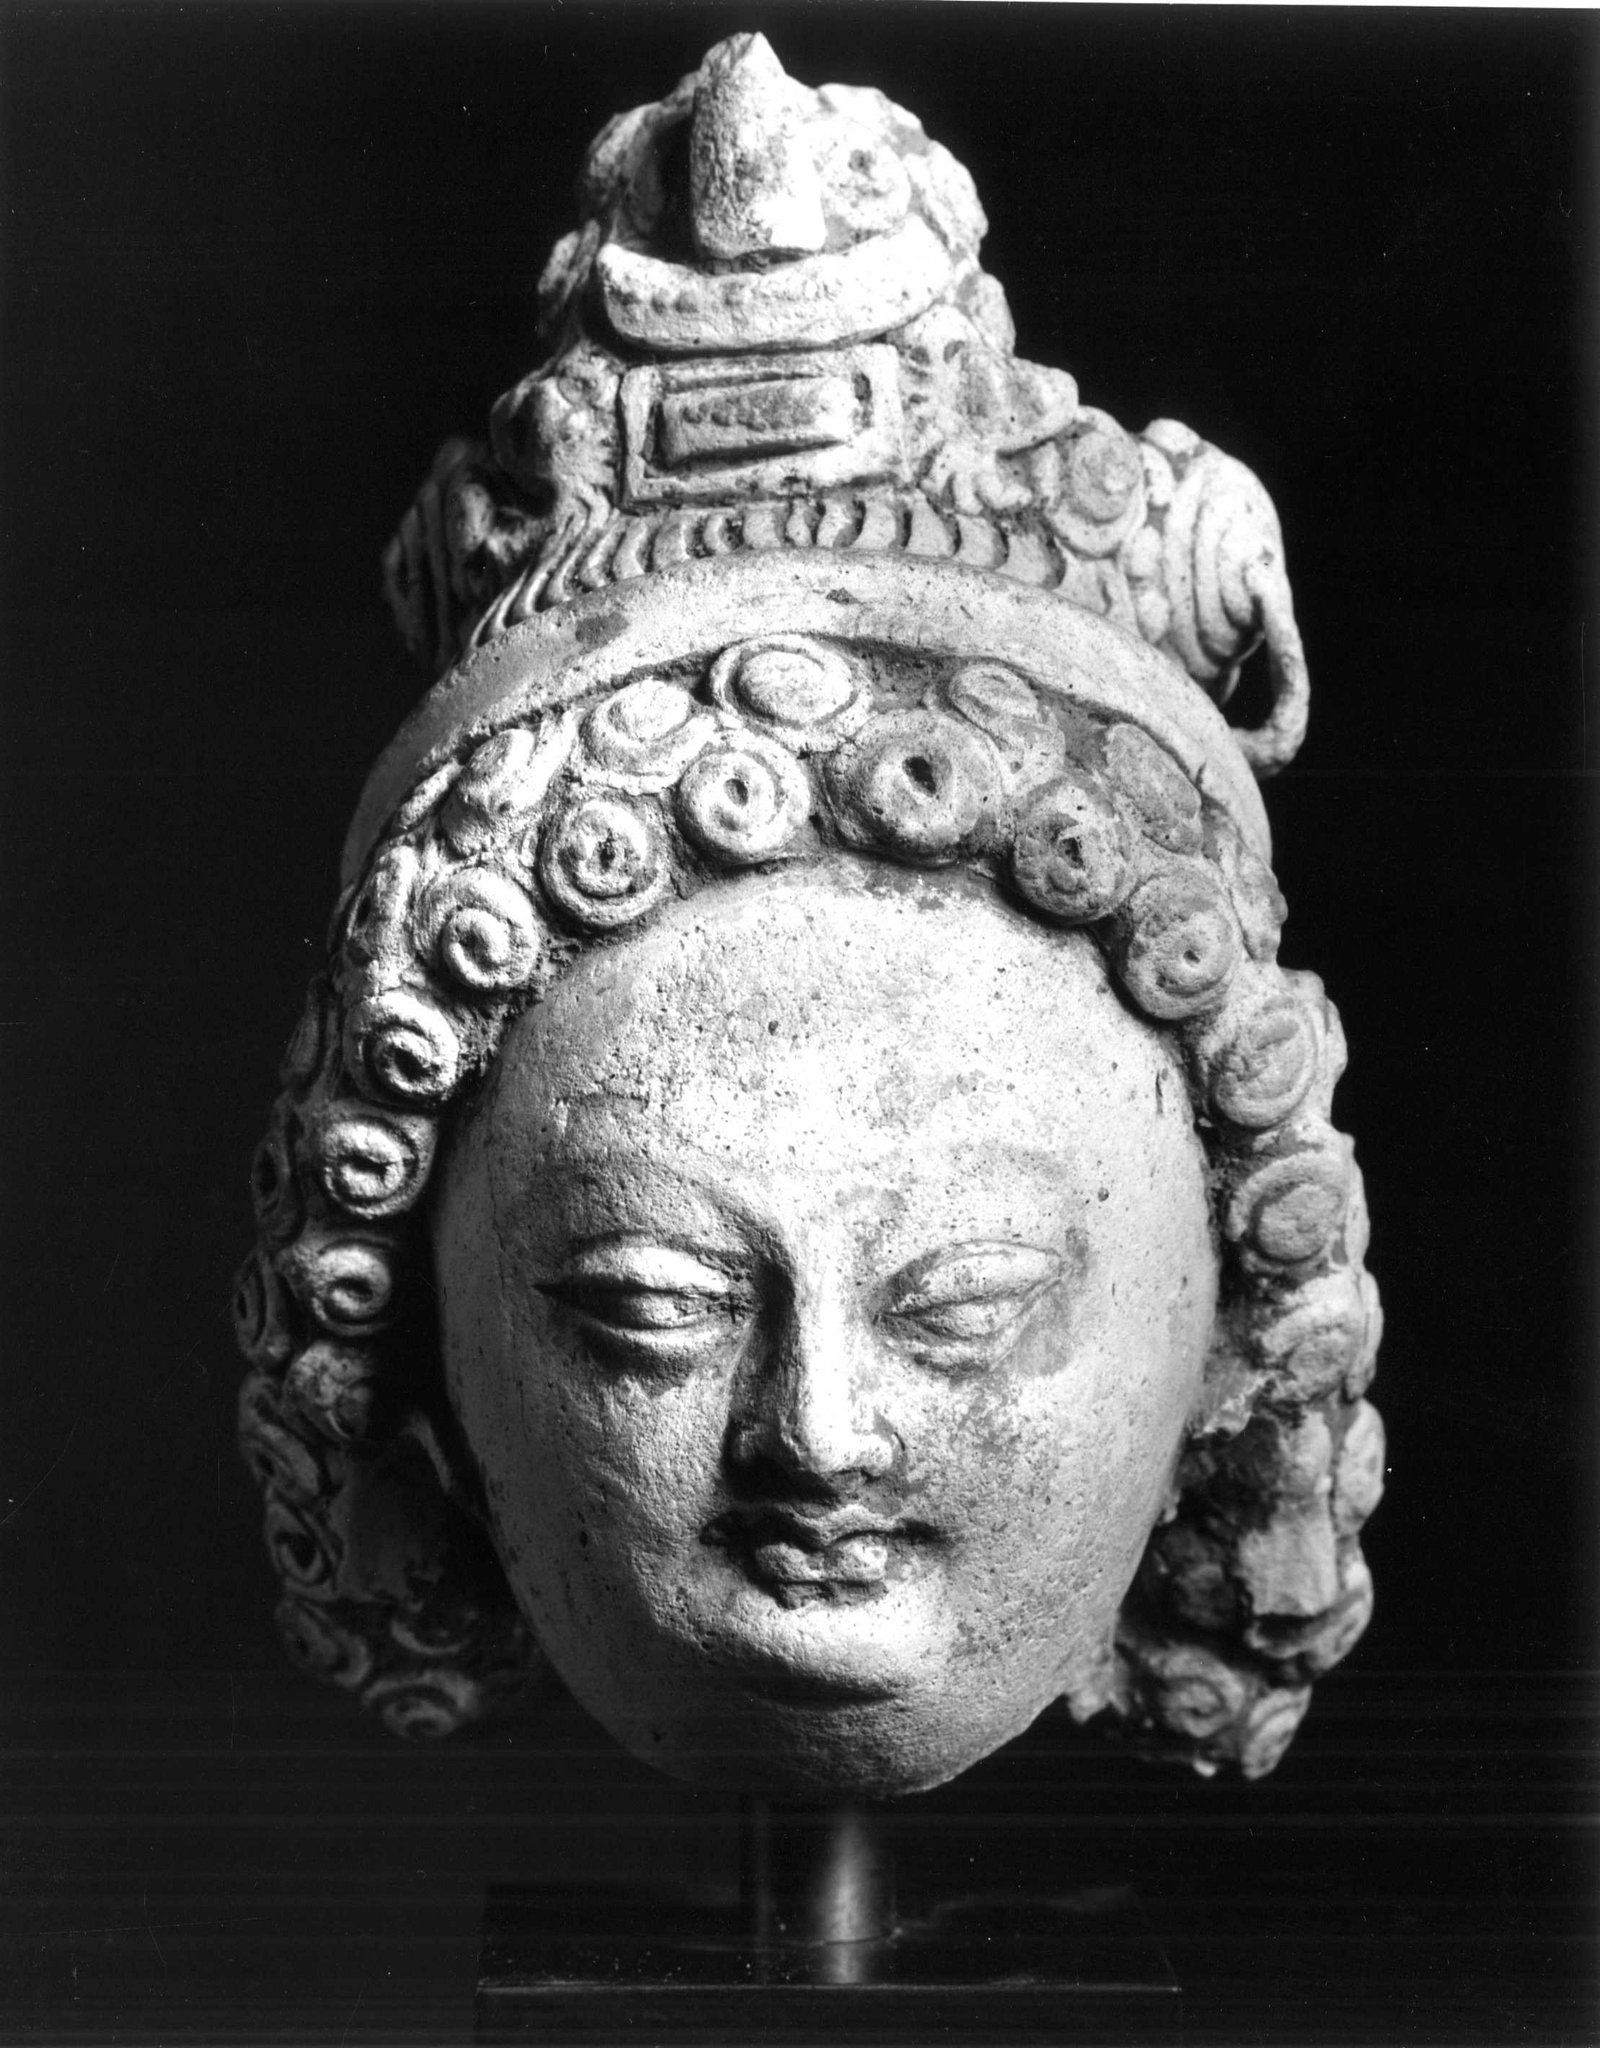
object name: head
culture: chinese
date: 701-1000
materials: gilt, paint, plaster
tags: heads